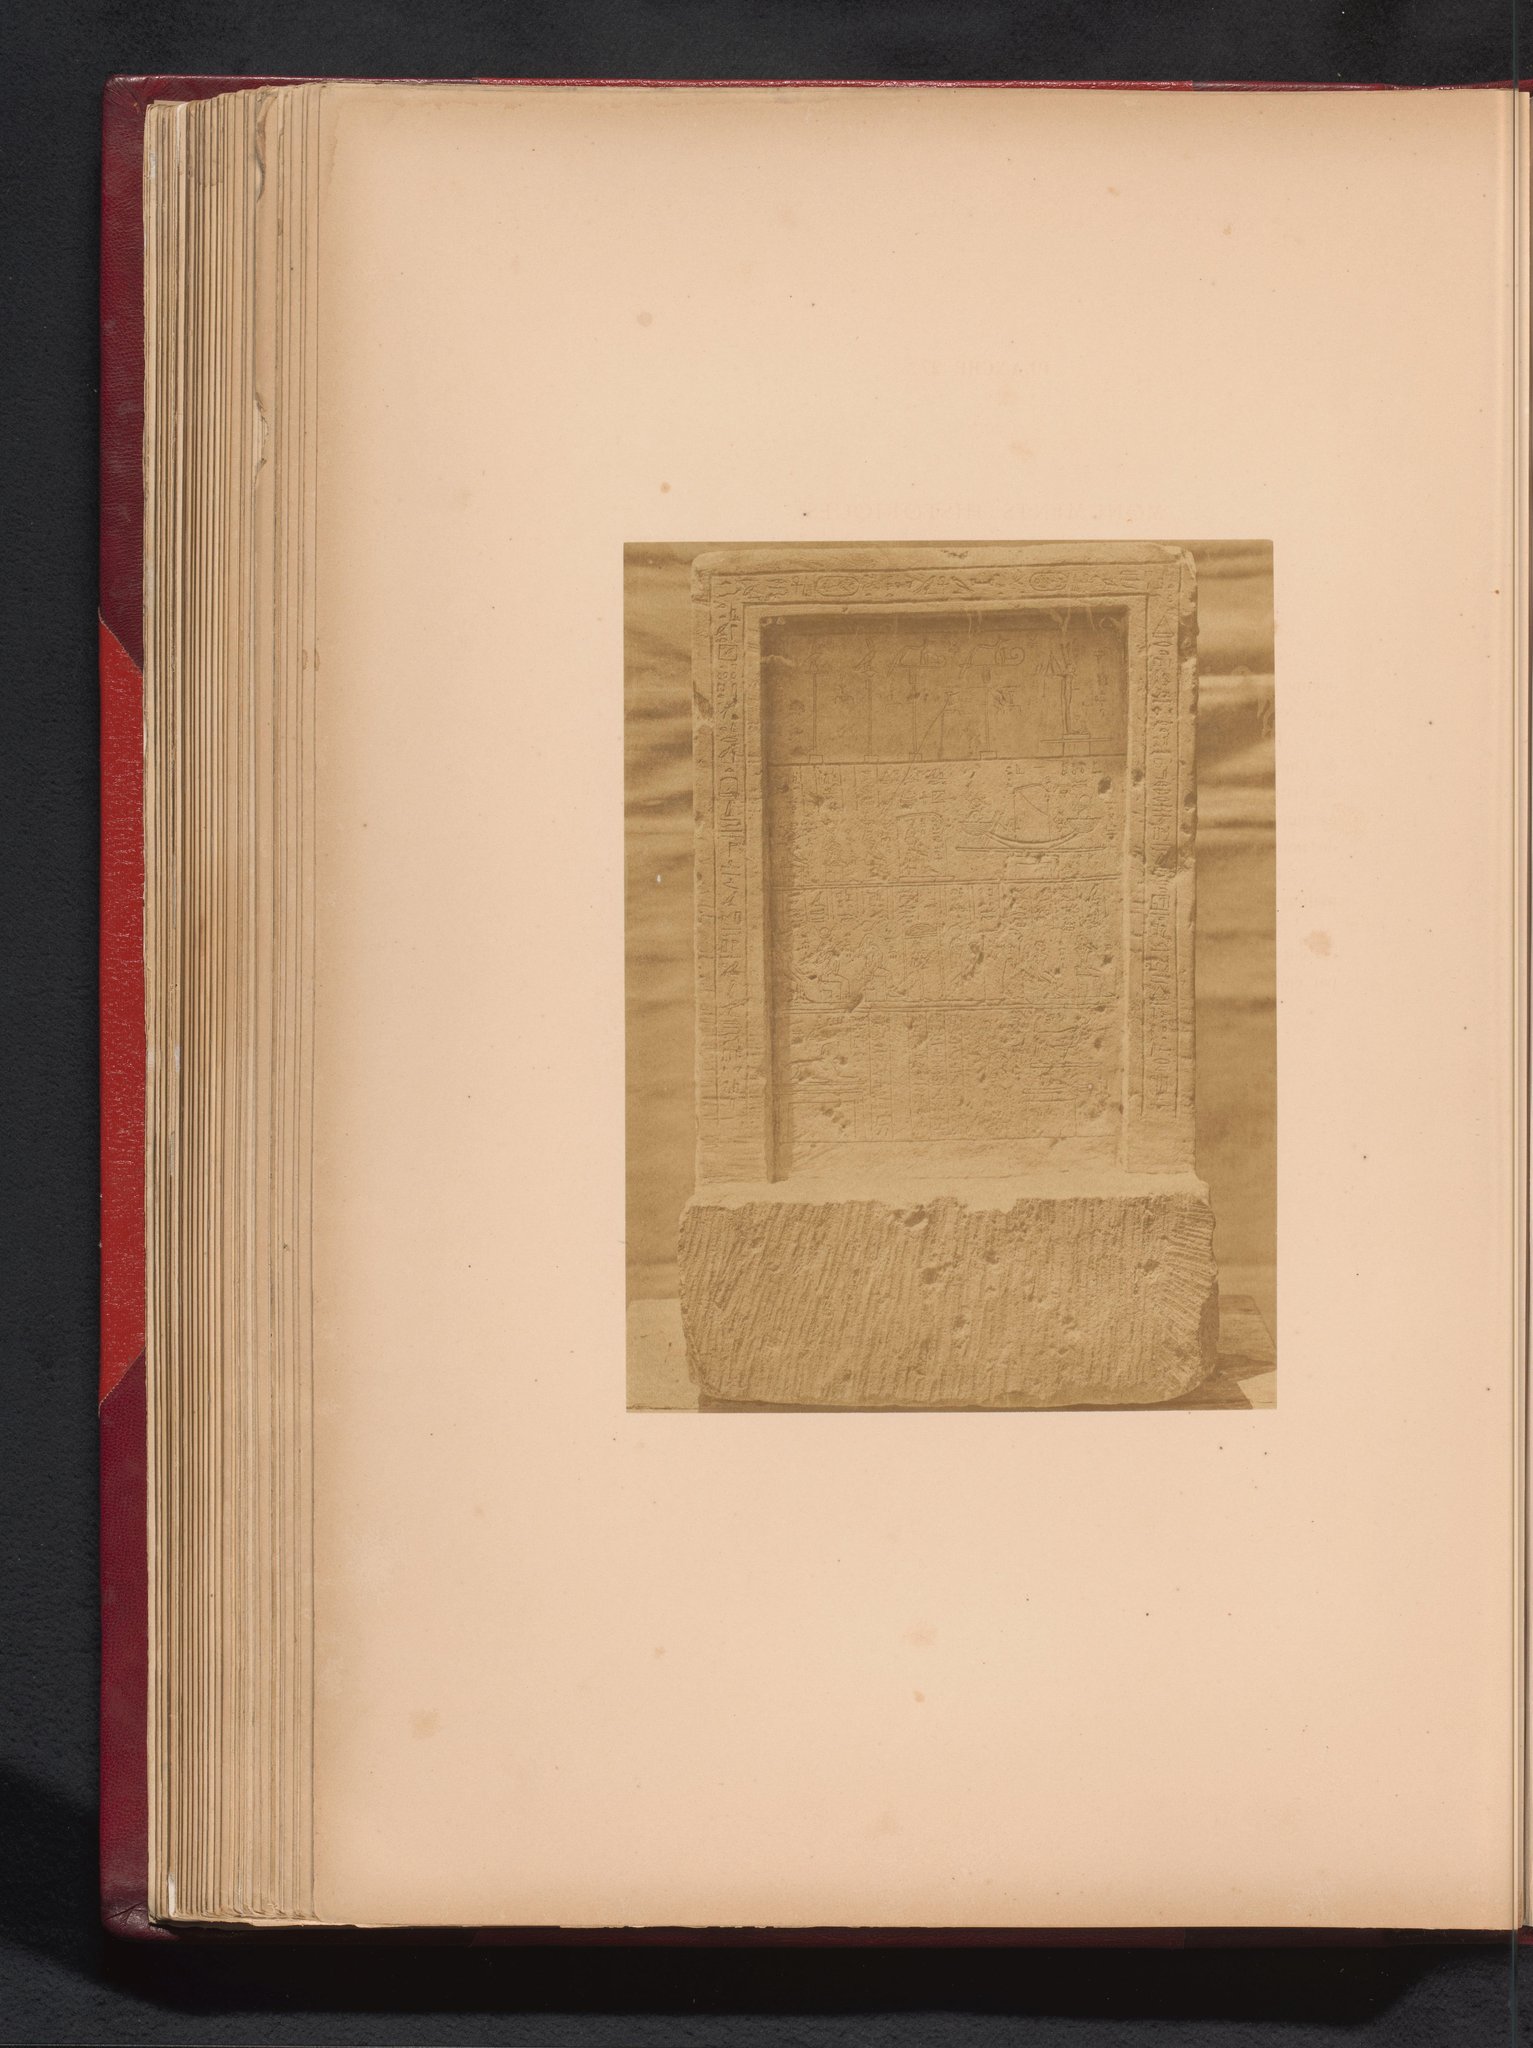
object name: photograph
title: Steen met inscriptie in het Boulaq Museum in Caïro, Egypte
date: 1866-1871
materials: photographic support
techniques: albumen print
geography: cairo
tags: inscription, permanent exhibition, museum